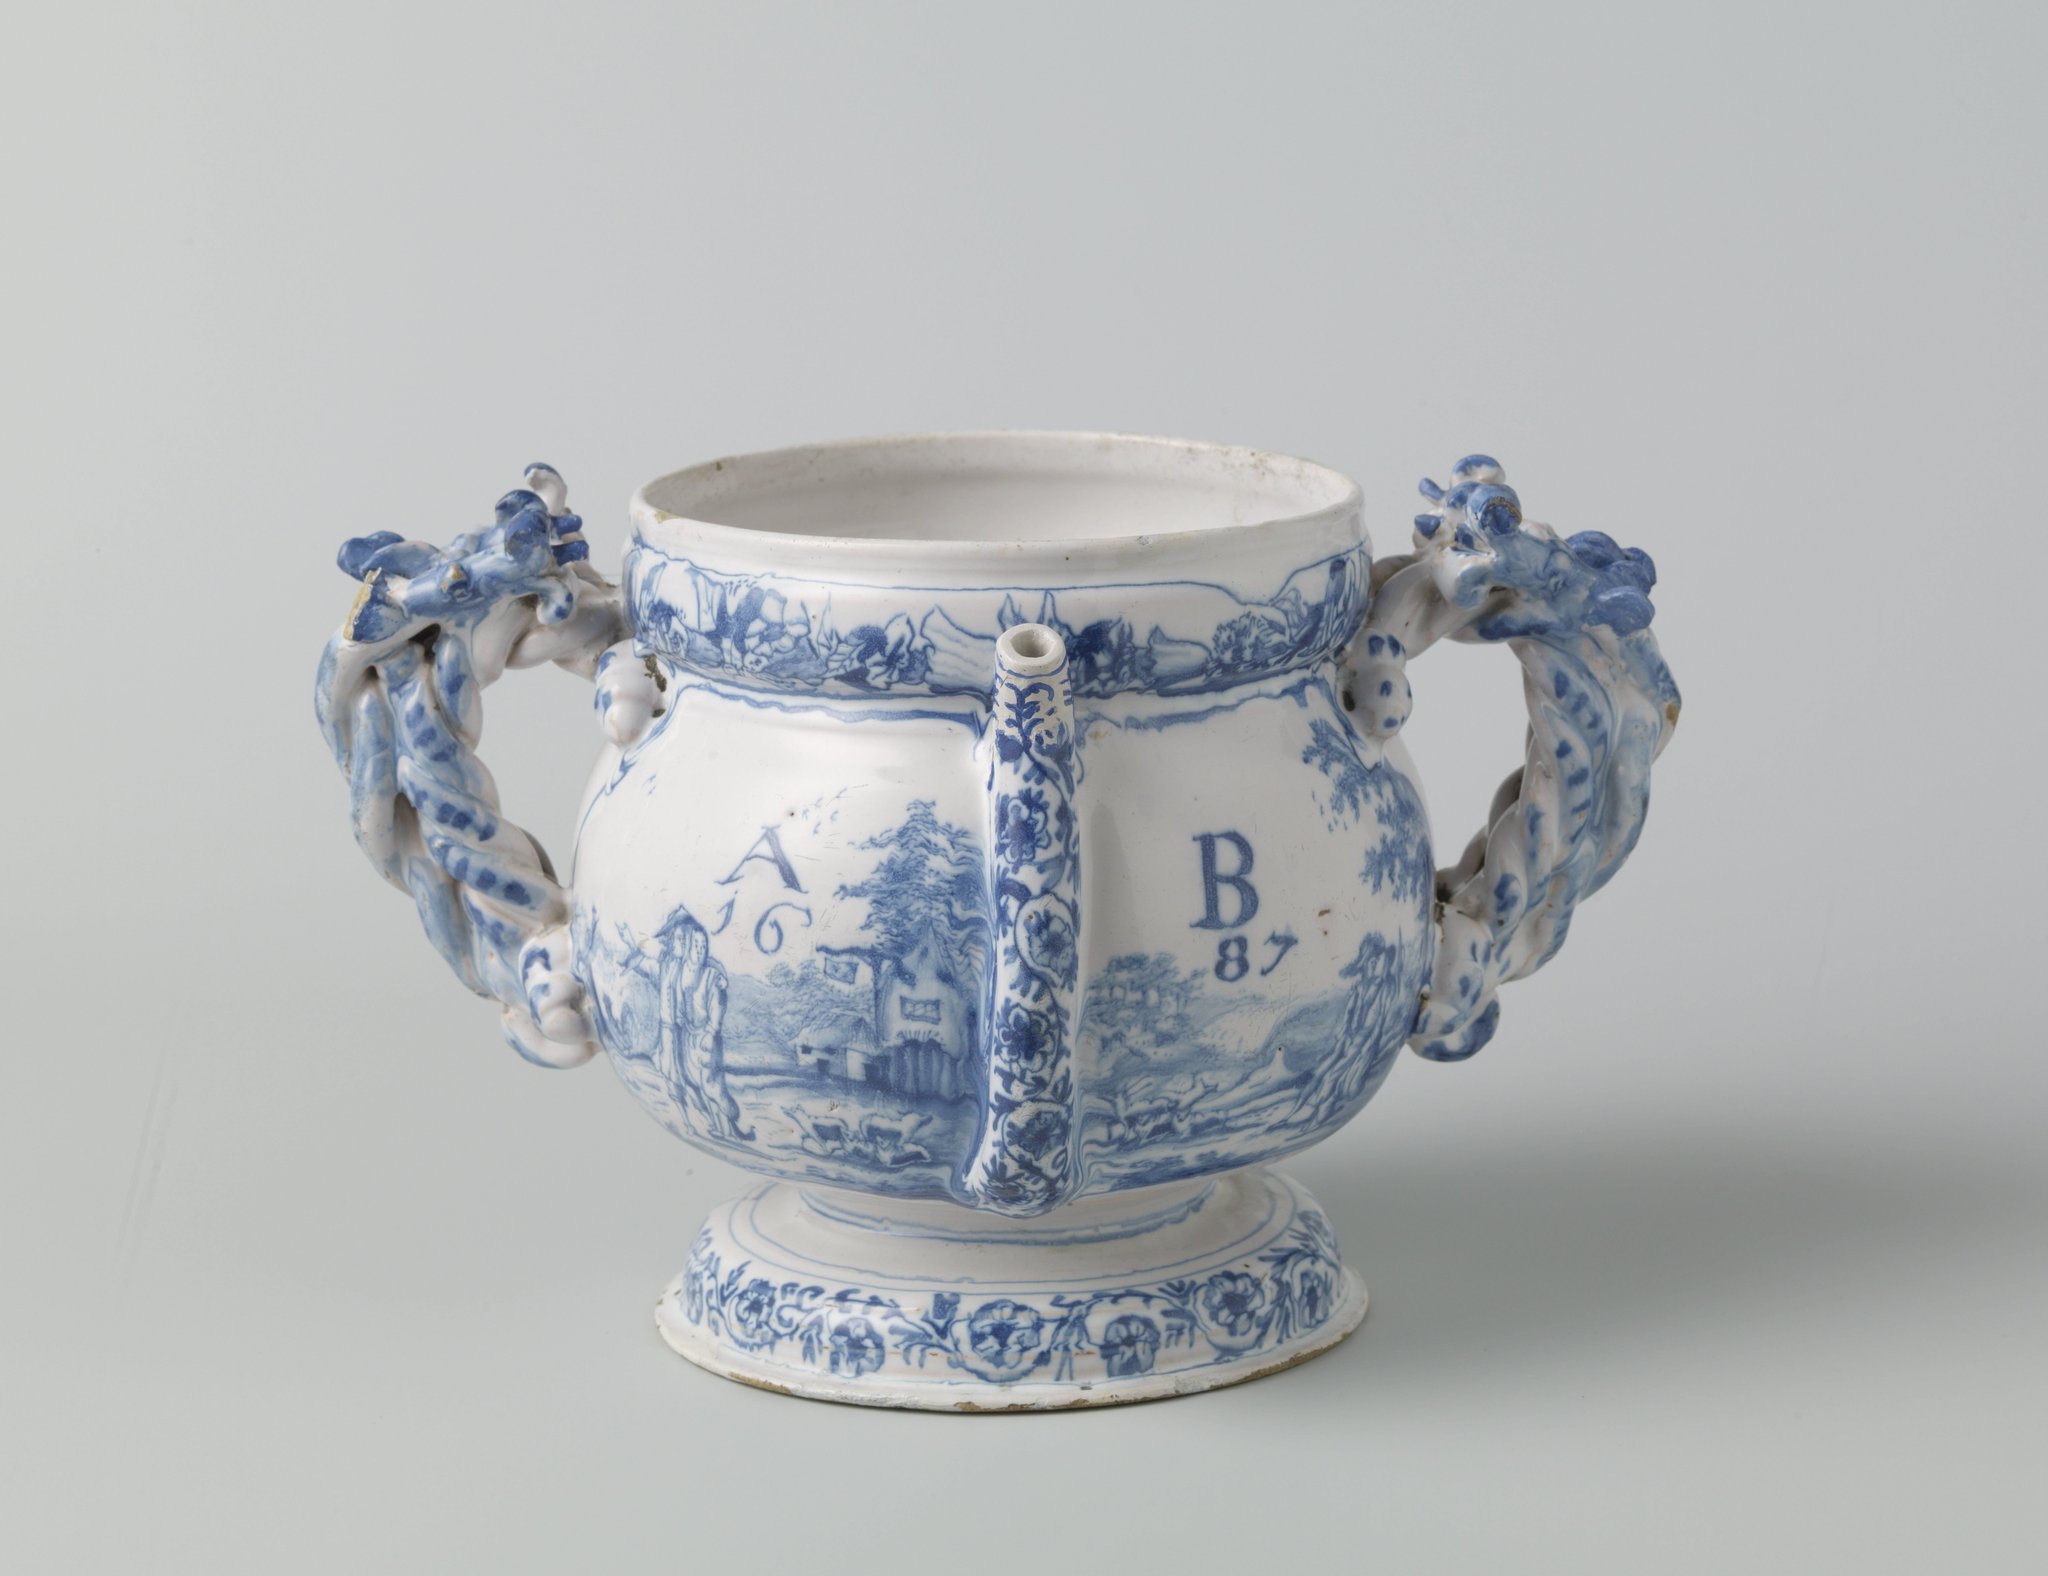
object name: flagon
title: Schenkkan met gevlochten oren beschilderd met landschap en minnekozende paren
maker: Anonymous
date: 1687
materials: earthenware, glaze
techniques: painted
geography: england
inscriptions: date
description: Half-bolvormige schenkkan van blauw beschilderde faïence, op een voet en met een aanliggende tuit. De kan heeft twee gevlochten c-vormige oren. Op de kan is een landschap geschilderd waarin drie minnekozende paren. De kan is gedateerd 1687.